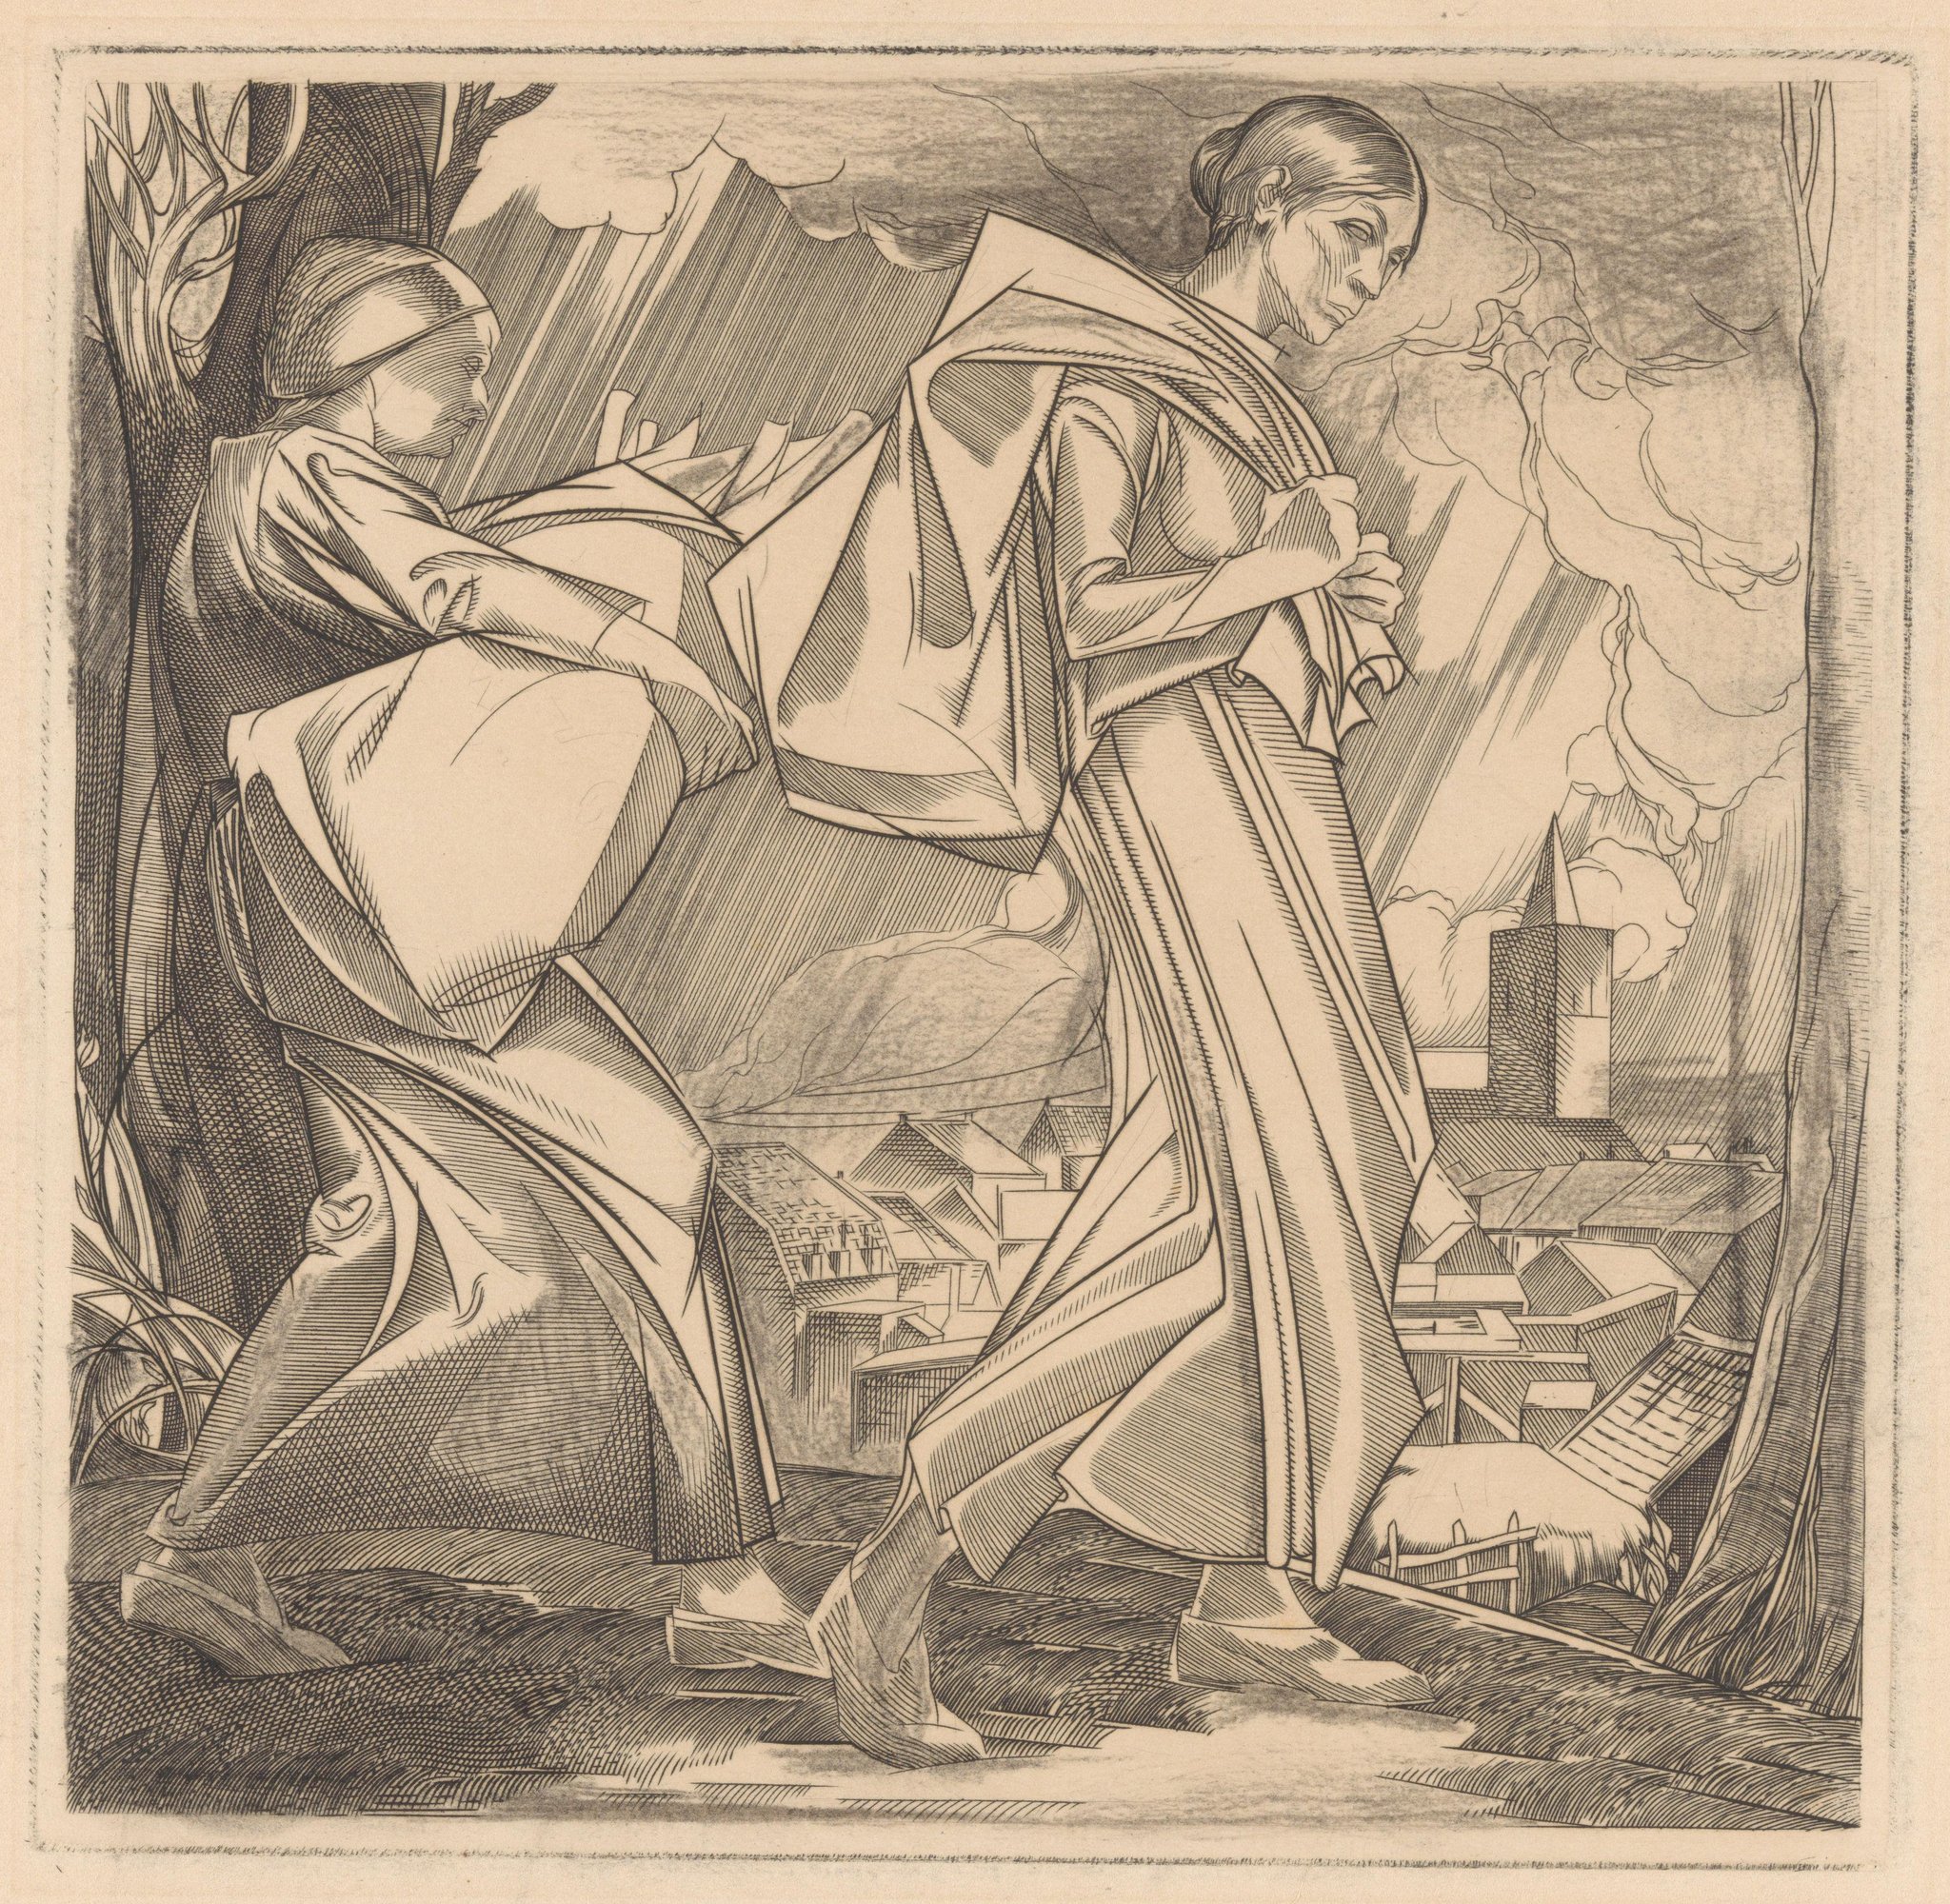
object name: print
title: Vluchtelingen in den oorlog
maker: johannes josephus aarts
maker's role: draughtsman, print maker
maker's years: 1871-1934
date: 1881-1934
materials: chalk, paper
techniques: engraving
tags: fugitives 'en route', container of textile material: bag, sack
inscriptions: collector's mark: Lugt 2760, collector's mark: Lugt 2166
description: Twee vrouwen in jurk dragen elk een zak met zich mee. Op de achtergrond een nederzetting met huizen en een kerk.